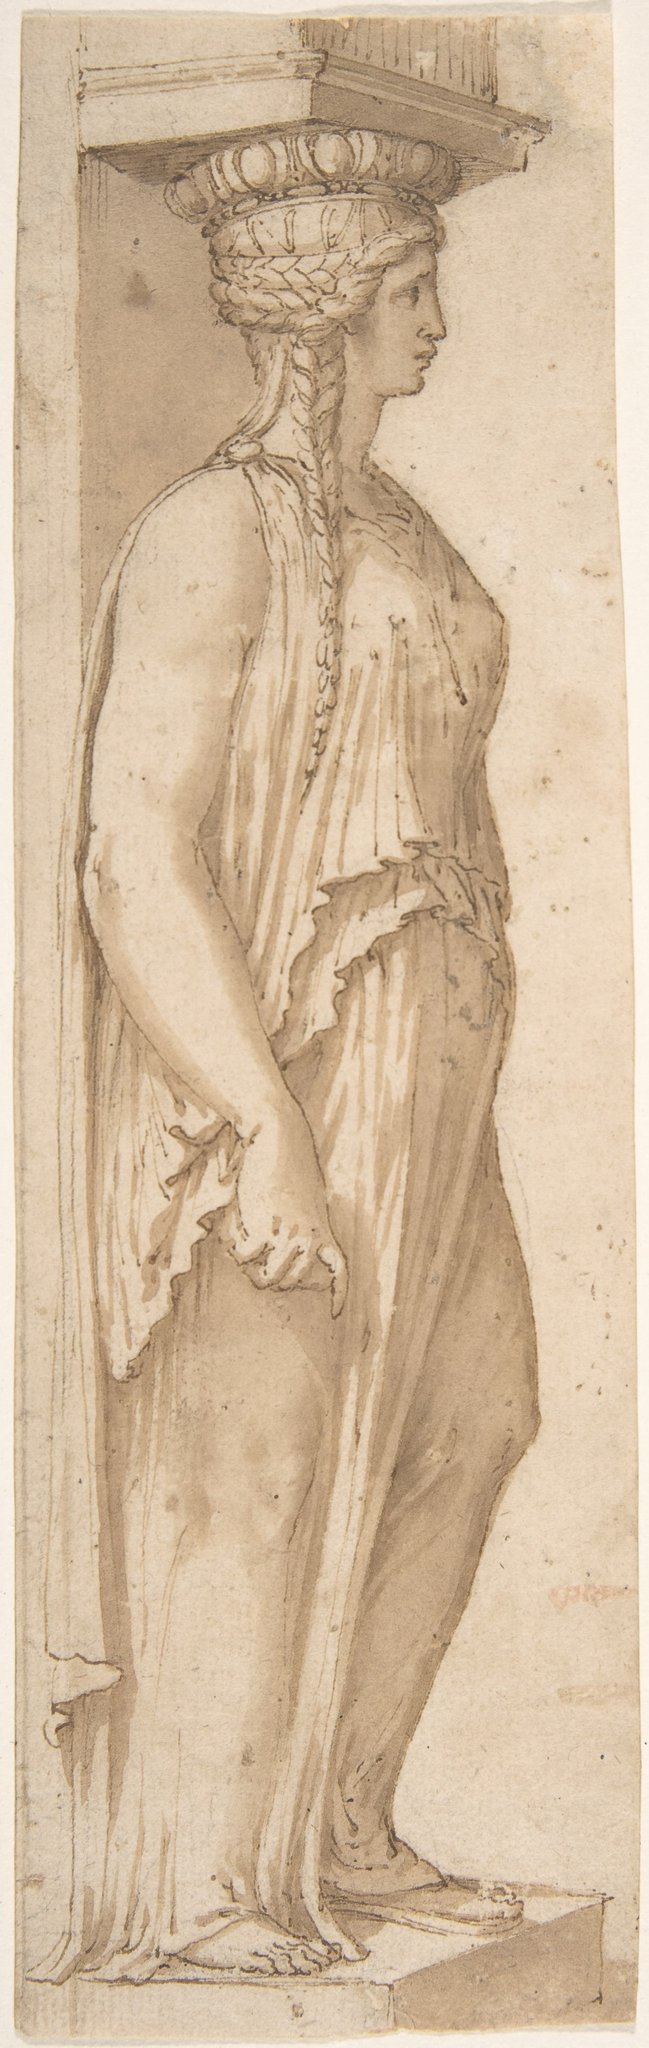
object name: drawing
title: Caryatid Facing Right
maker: pirro ligorio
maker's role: artist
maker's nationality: italian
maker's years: 1512-1583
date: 1534-1566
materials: chalk, ink, drawing material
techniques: brush, pen, wash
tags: caryatids